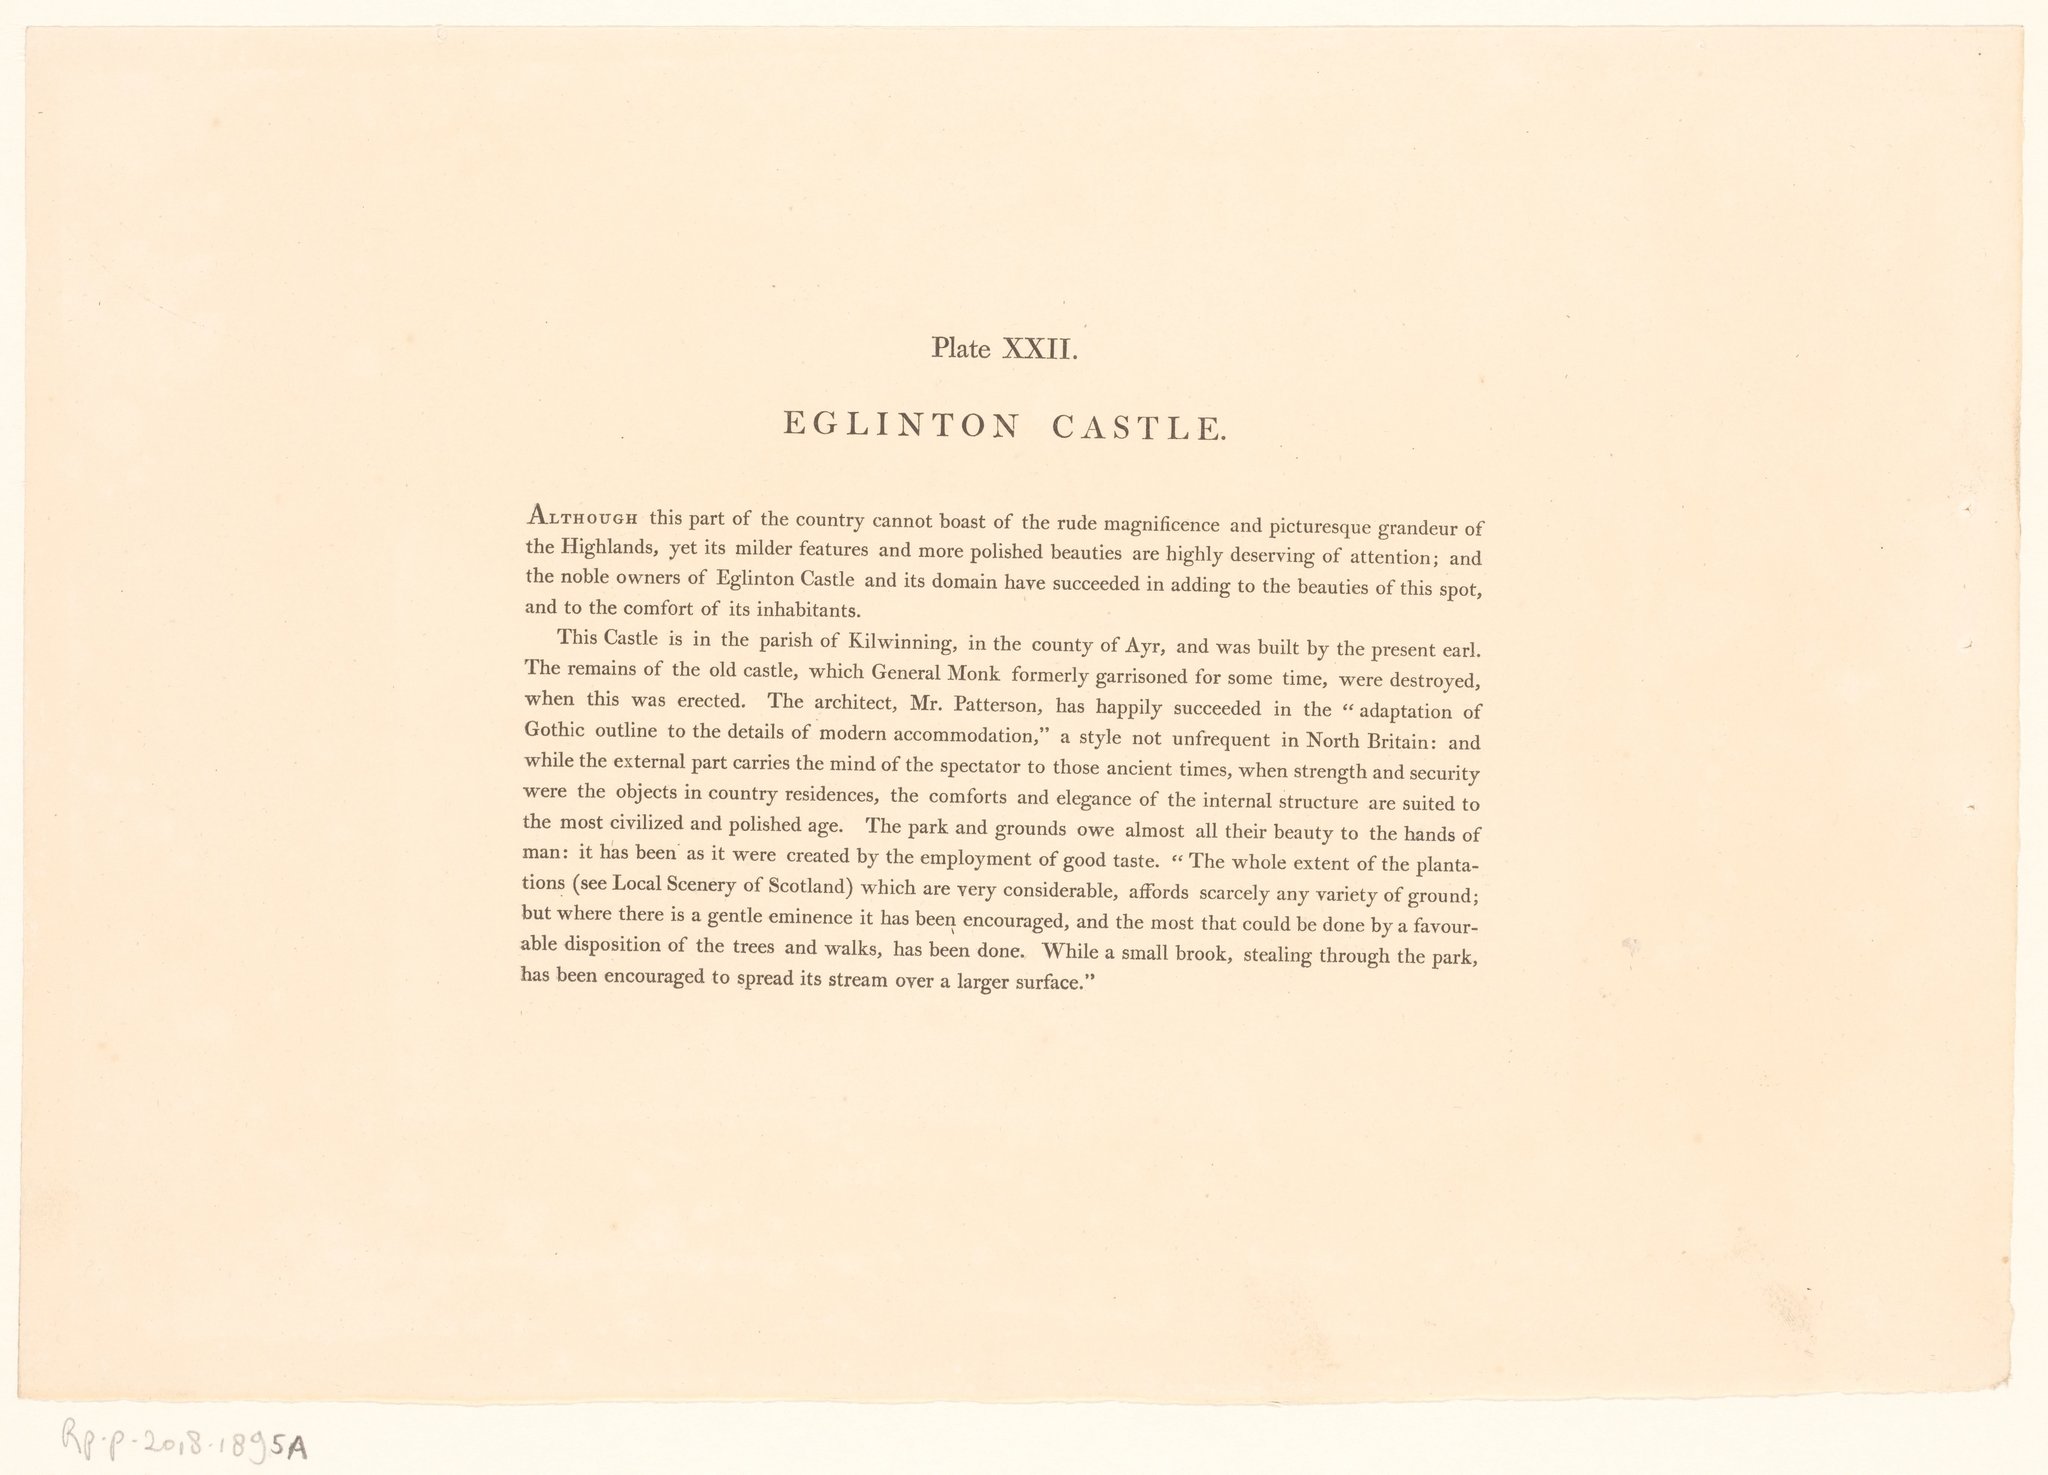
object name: text sheet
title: Plate XXII. Eglinton Castle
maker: william miller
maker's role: bookseller, printer, publisher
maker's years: 1769-1844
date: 1801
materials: paper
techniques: letterpress printing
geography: london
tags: ayrshire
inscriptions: collector's mark: Lugt 2228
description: Tekstblad gebruikt in: Scotia Depicta; or the antiquities, castles, public buildings, noblemen (...). Londen: William Miller, 1801.